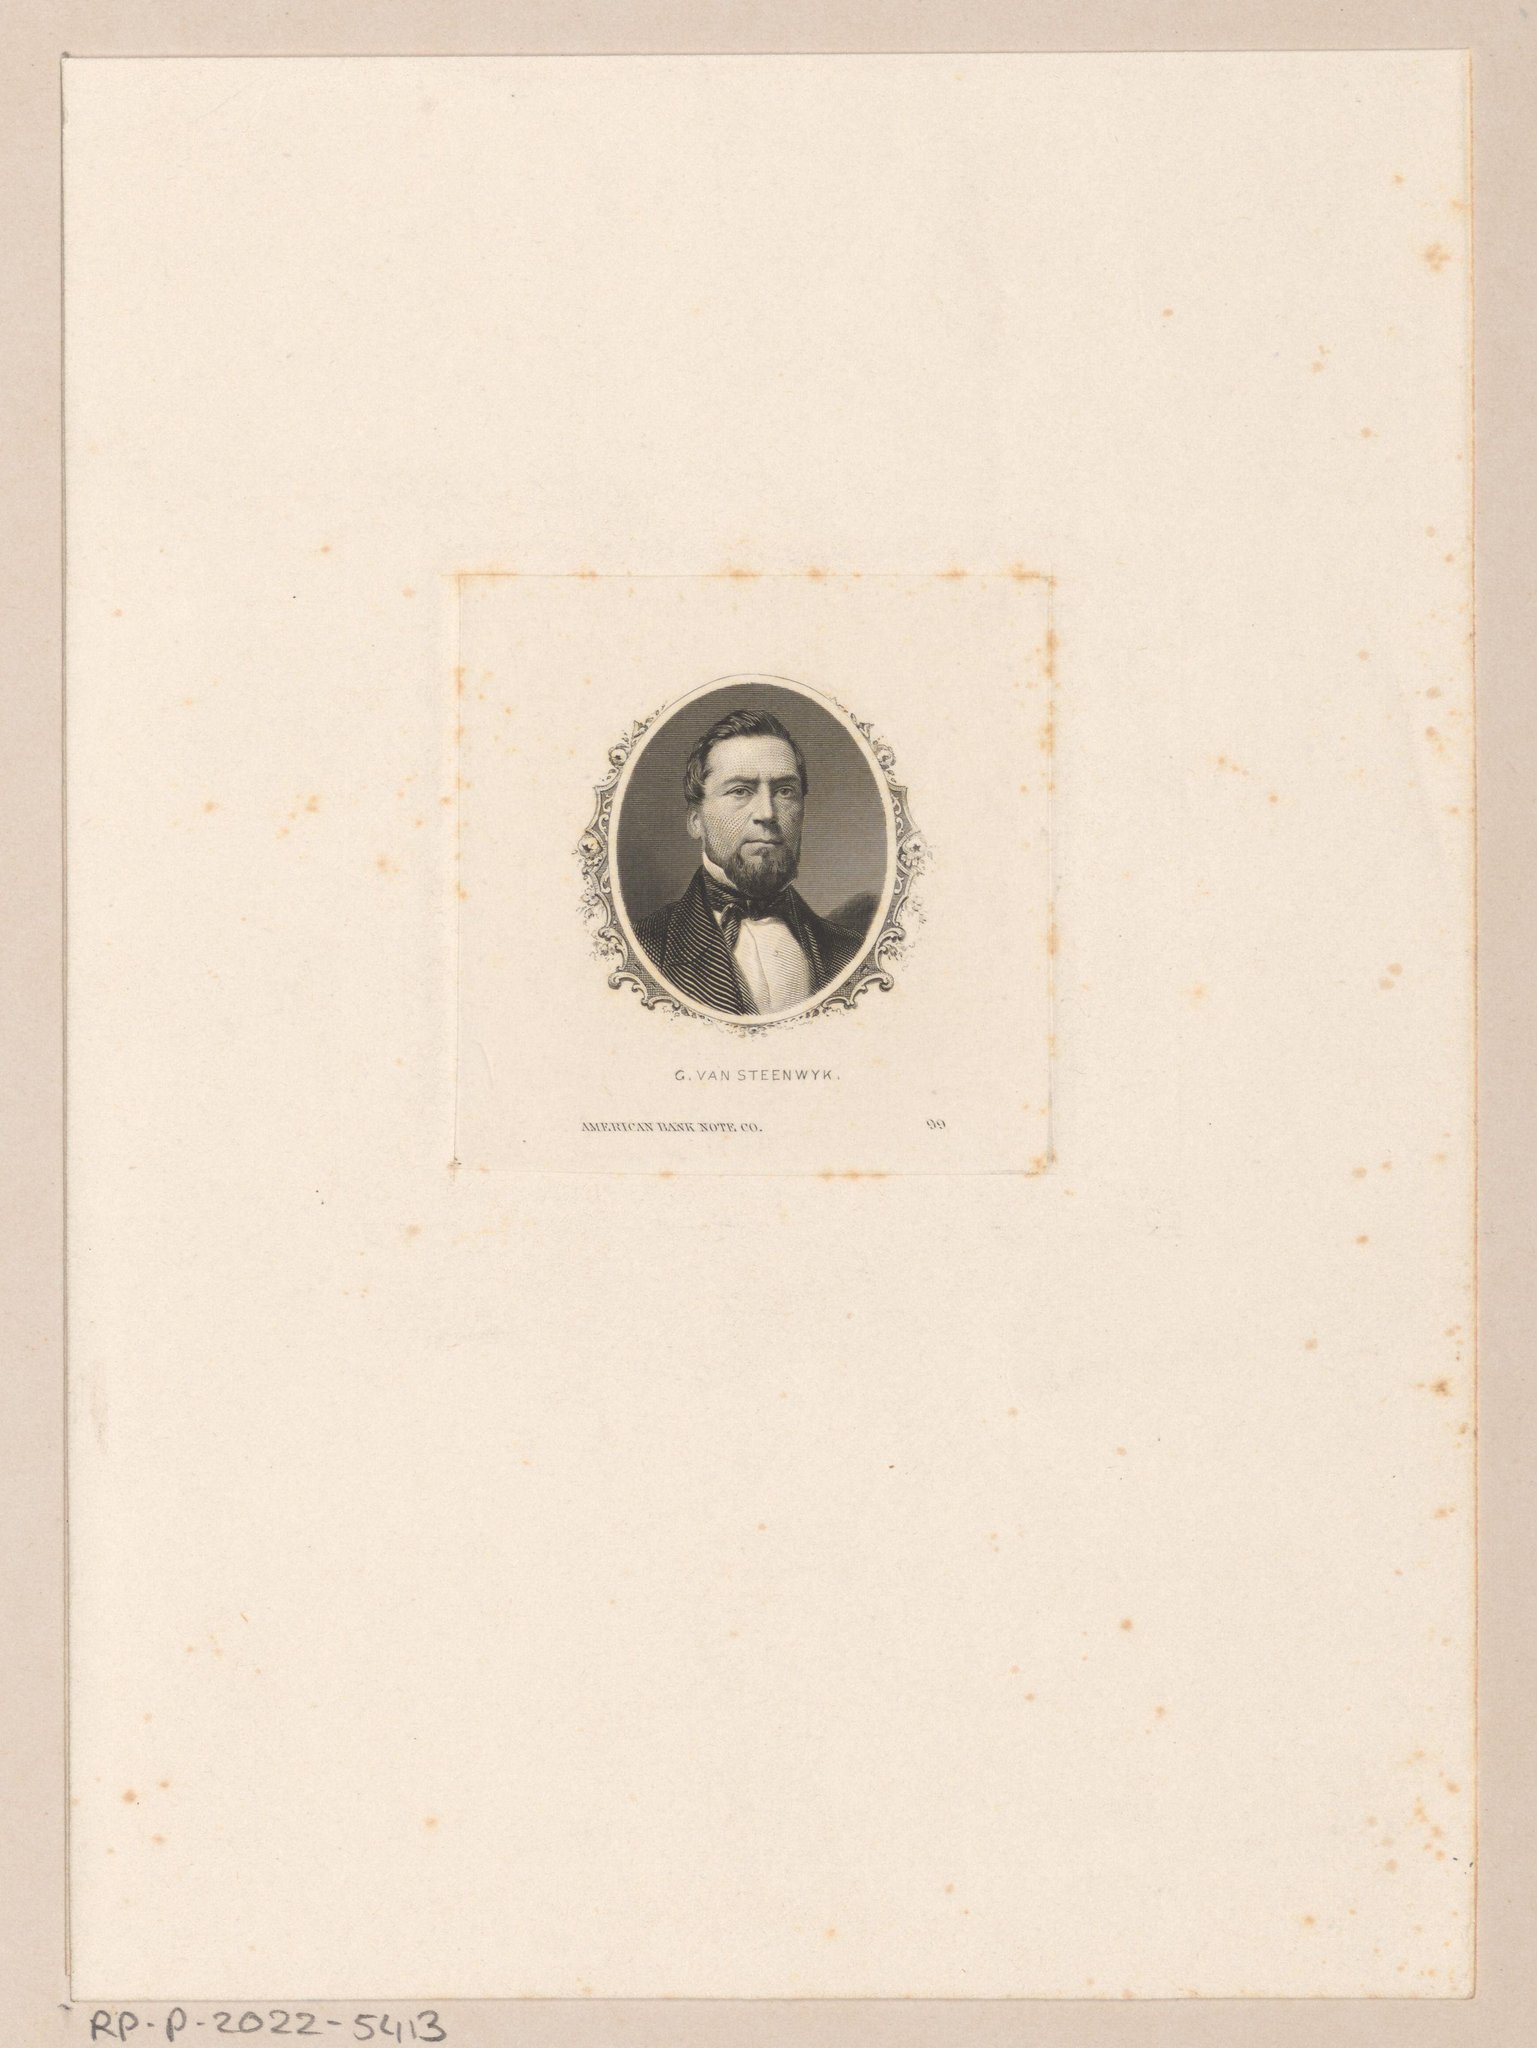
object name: print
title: Portret van G. van Steenwyk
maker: Anonymous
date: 1820-1950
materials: paper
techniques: engraving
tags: historical persons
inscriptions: inscription: ‘Gijsbertus van Steenwijk 10 1/2 jaar / ingeschreven 1824’